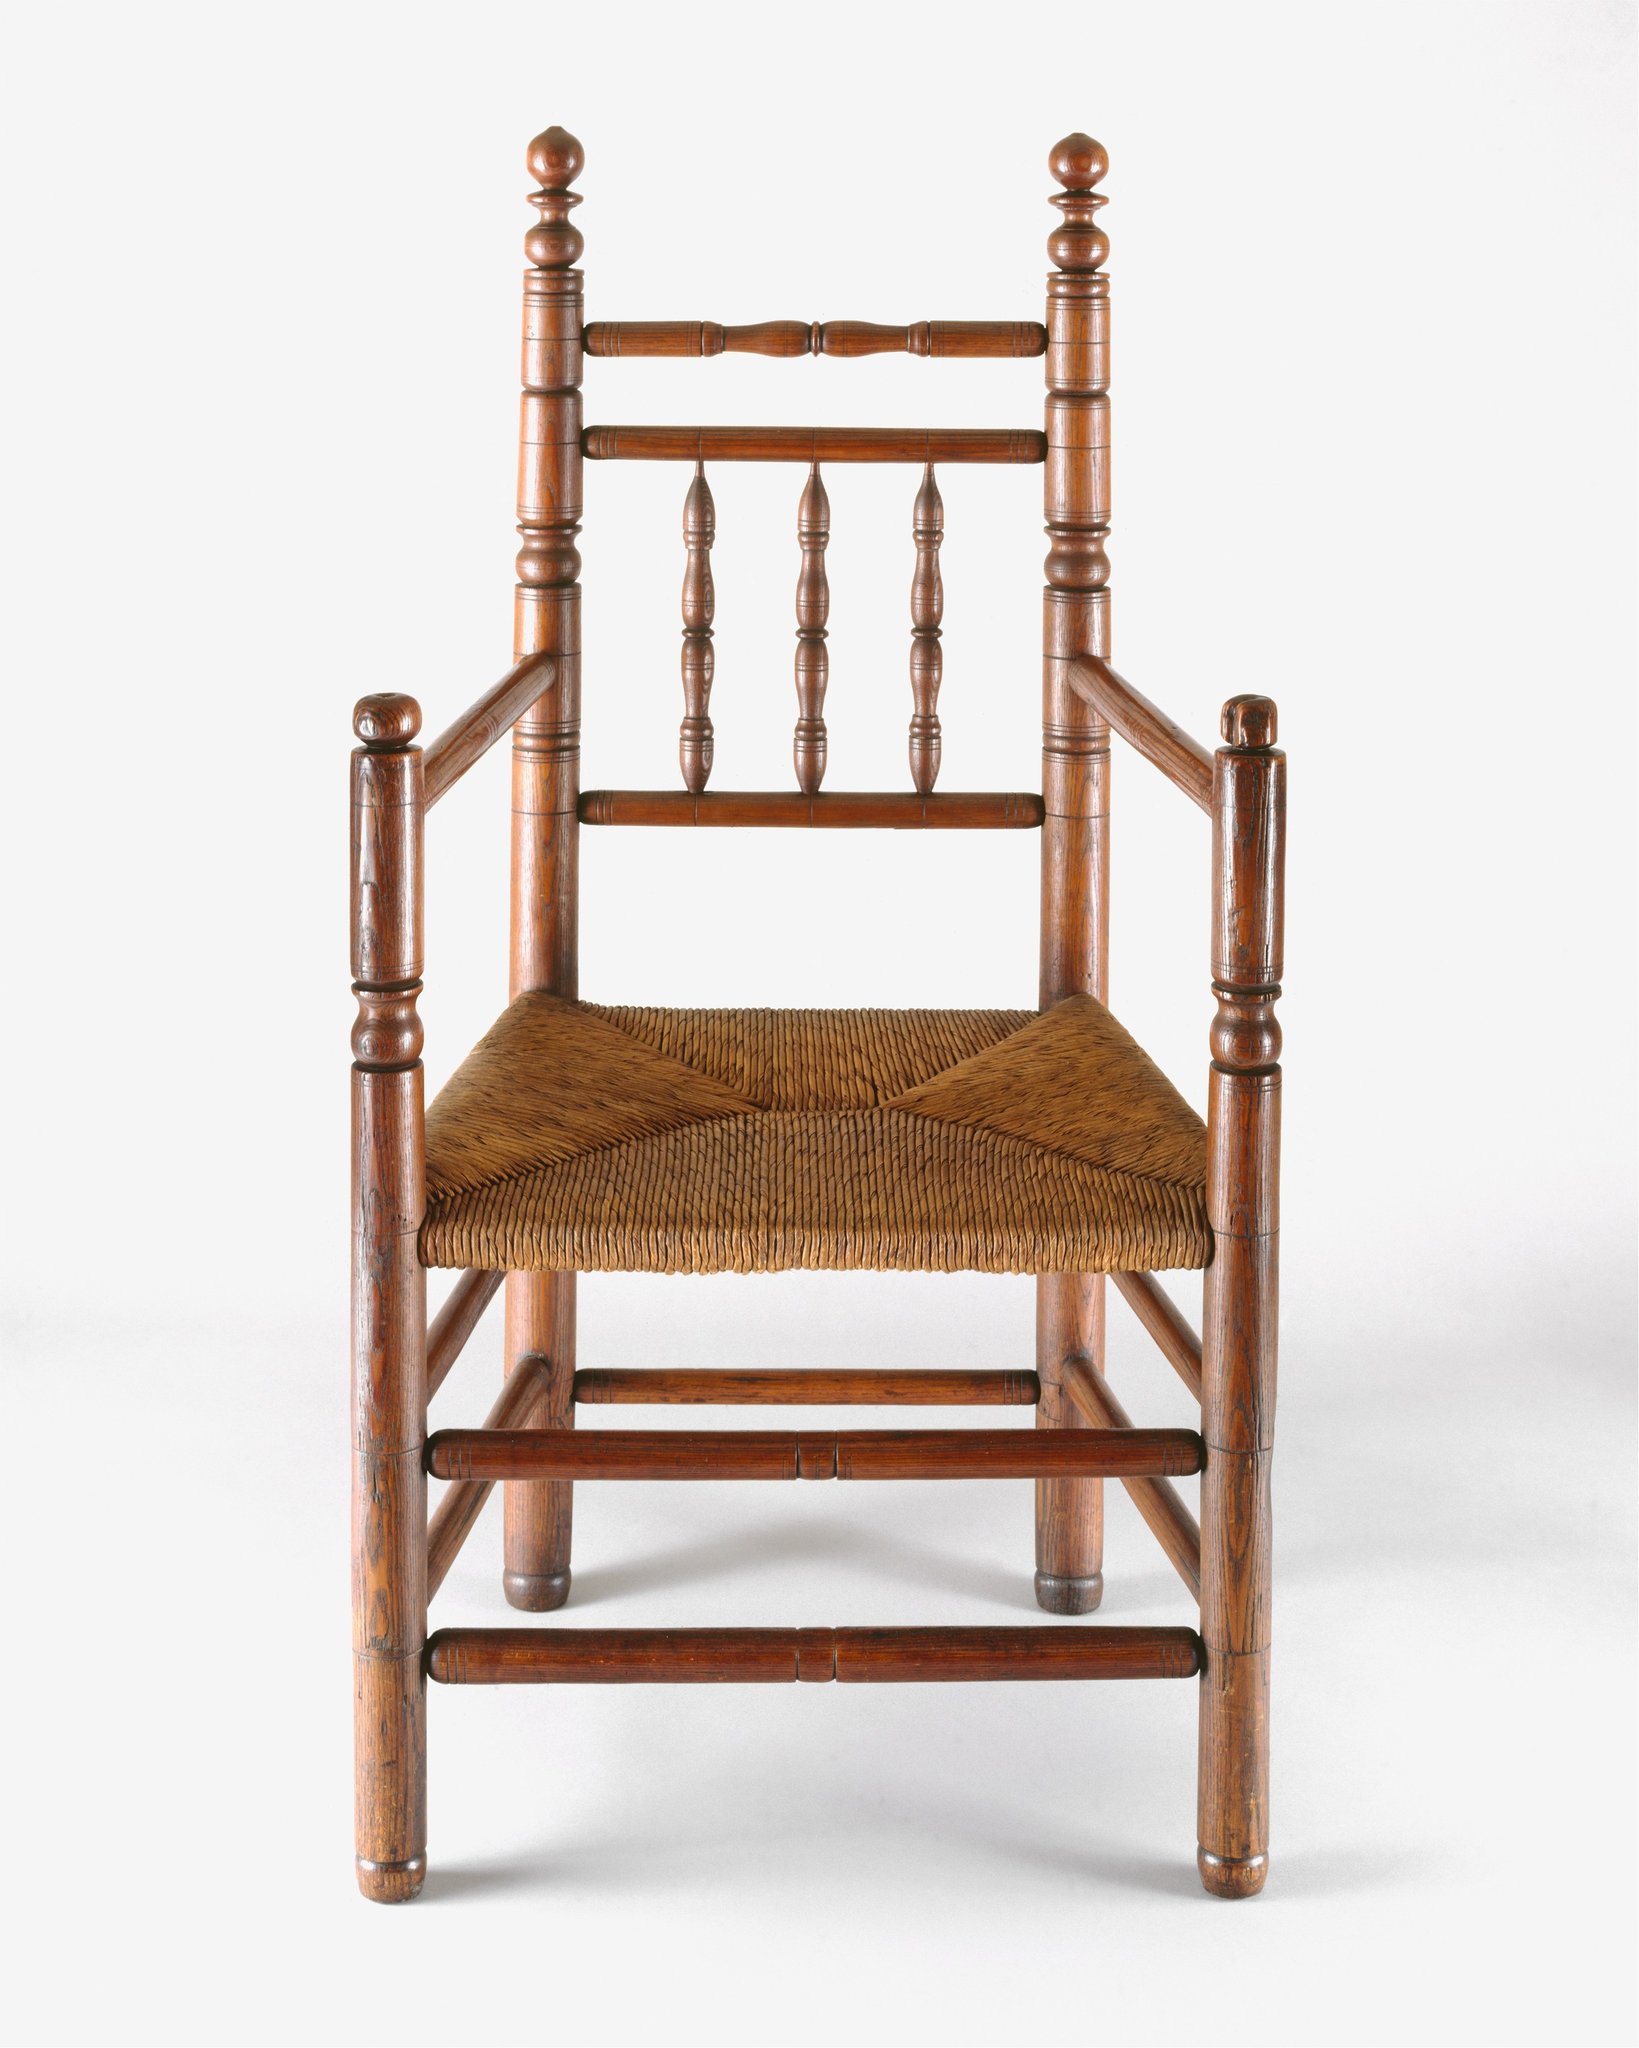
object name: spindle back chair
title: Spindle-back armchair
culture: american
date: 1660-1700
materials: wood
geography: united states